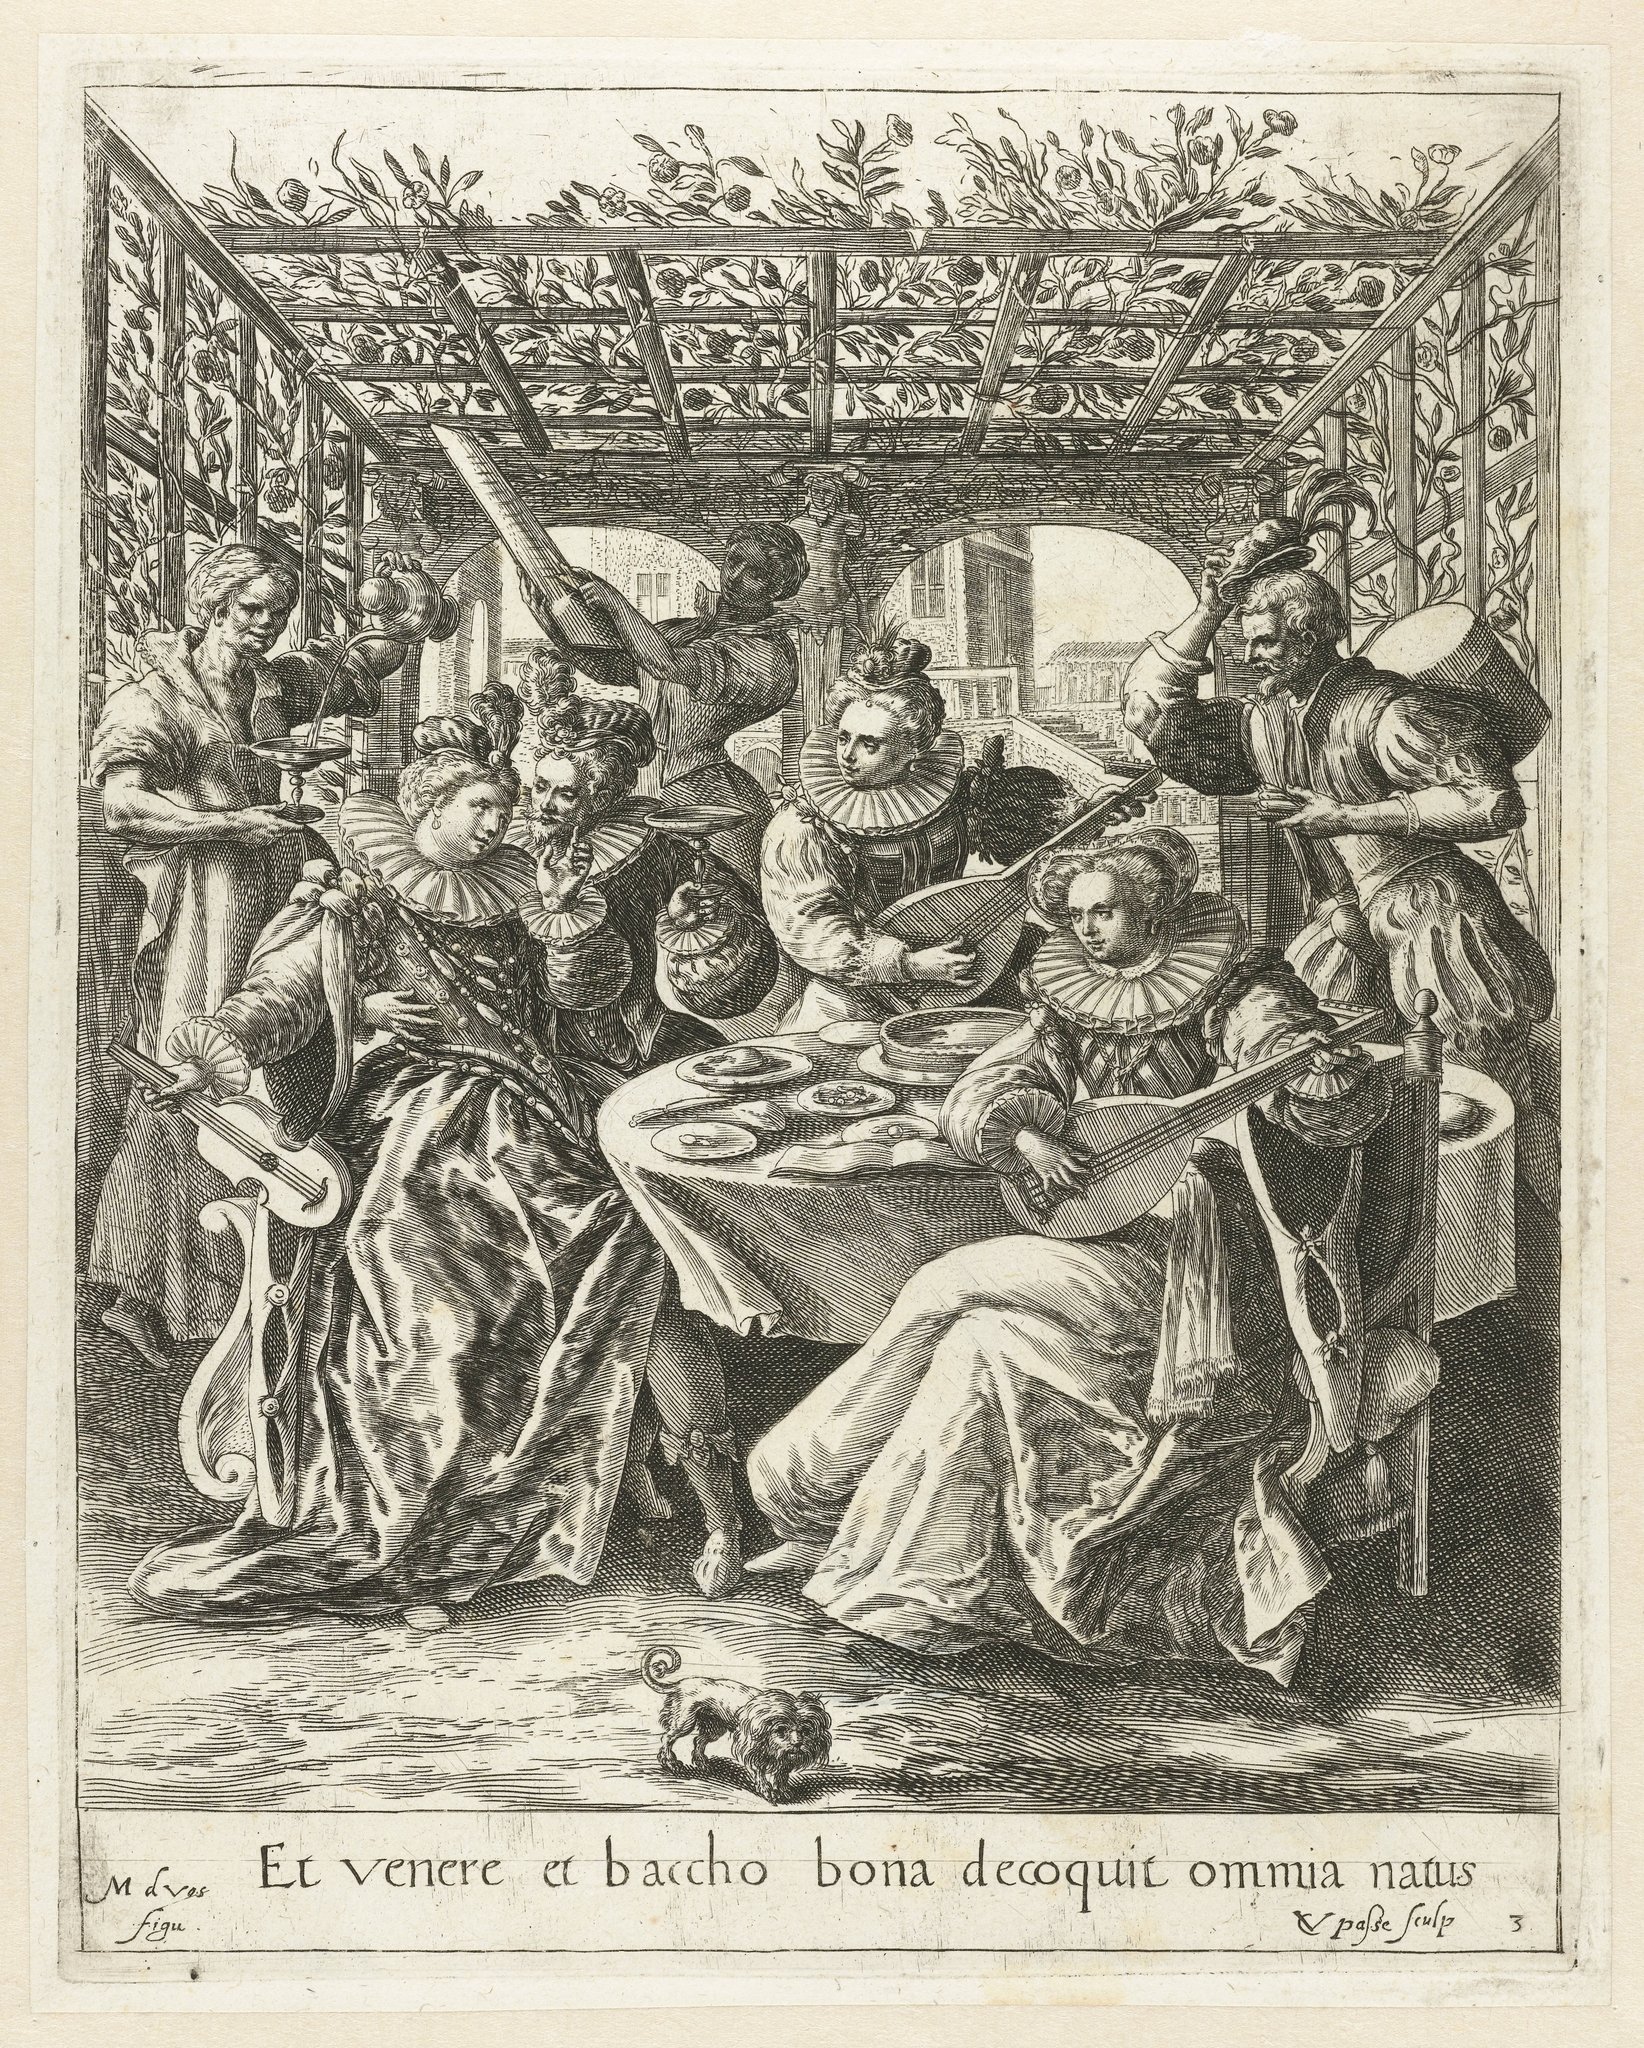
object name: print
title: Gelijkenis van de verloren zoon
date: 1580-1588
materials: paper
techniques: engraving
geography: antwerp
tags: brothel, clothes, costume (+ women's clothes), neck-gear ~ clothing (with name) (+ women's clothes), clothes, costume (+ men's clothes), 'sine cerere et baccho friget venus', lute, and special forms of lute, e.g.: theorbo, the prodigal son in the midst of prostitutes feasting and dissipating his patrimony, usually in a brothel or inn, more than one musician with instrument, private festivities, merry company, head-gear (with name) (+ women's clothes)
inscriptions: collector's mark: Lugt 2228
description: De dames dragen Spaanse hoedjes* met hoge bol en een kleine platte rand, versierd met strik en veren. Molenstaankragen* en geplooide manchetten.